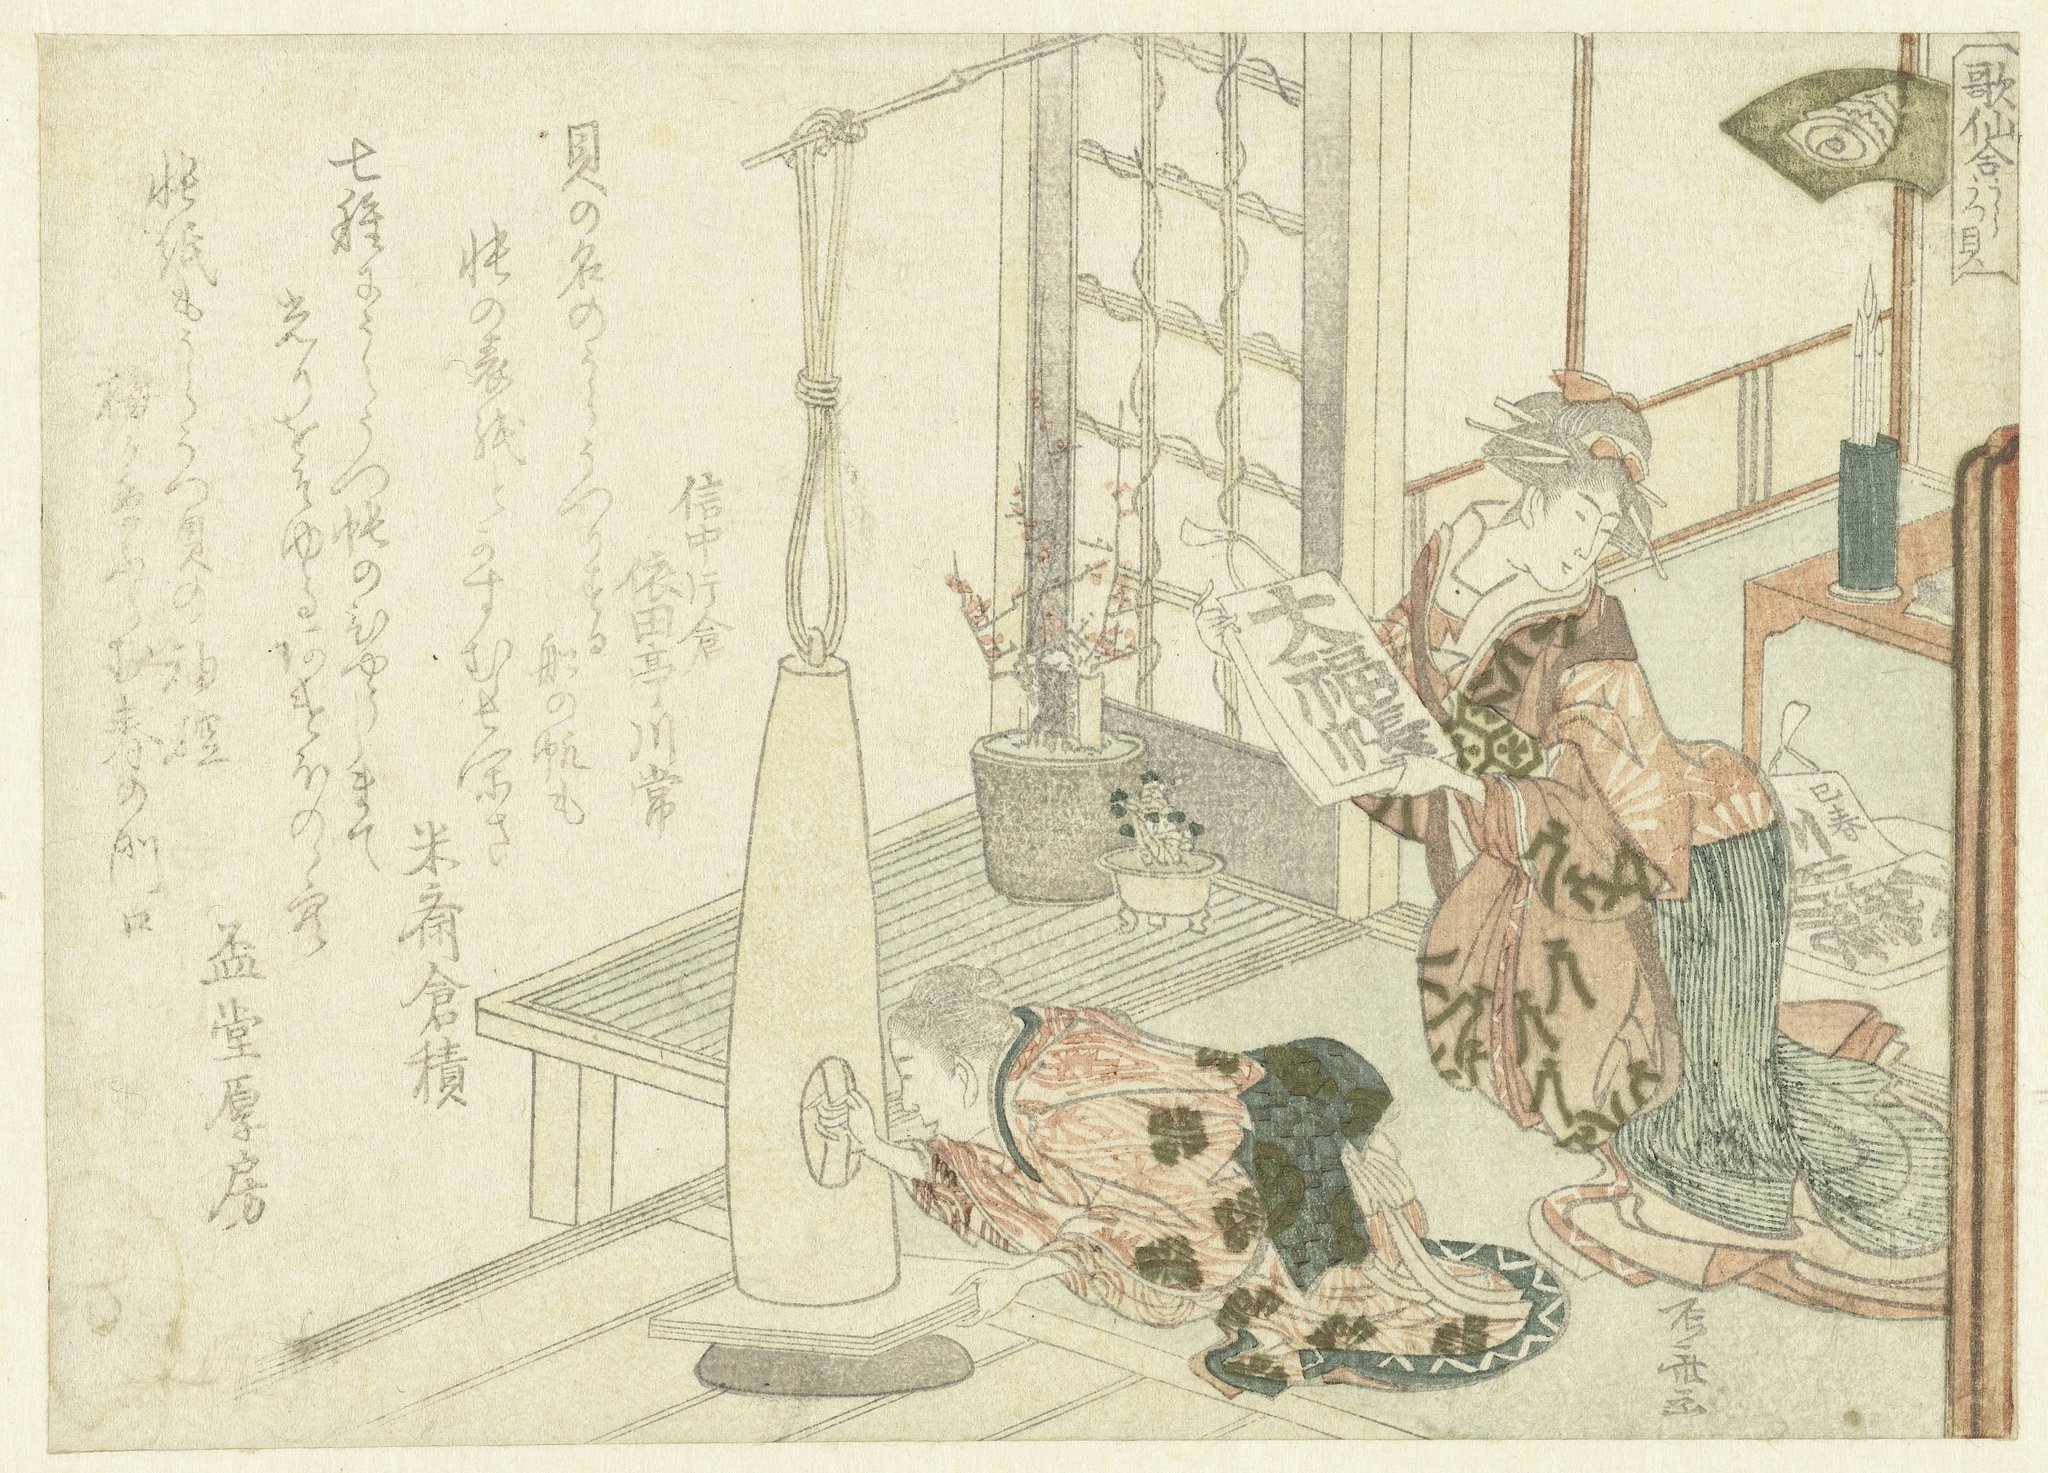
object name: print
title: Backing shell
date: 1809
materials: paper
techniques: woodcut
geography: japan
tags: bookbinding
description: Een surimono is een luxe uitgevoerde prent waarop beeld met één of meerdere gedichten gecombineerd is. Bij het drukken van een surimono werd vaak gebruik gemaakt van dikker papier, blinddruk en metaal pigmenten, zoals koper- en zilverpoeder. De prenten werden vaak in opdracht van dichters gemaakt en als exclusief geschenk aan vrienden en relaties gegeven.